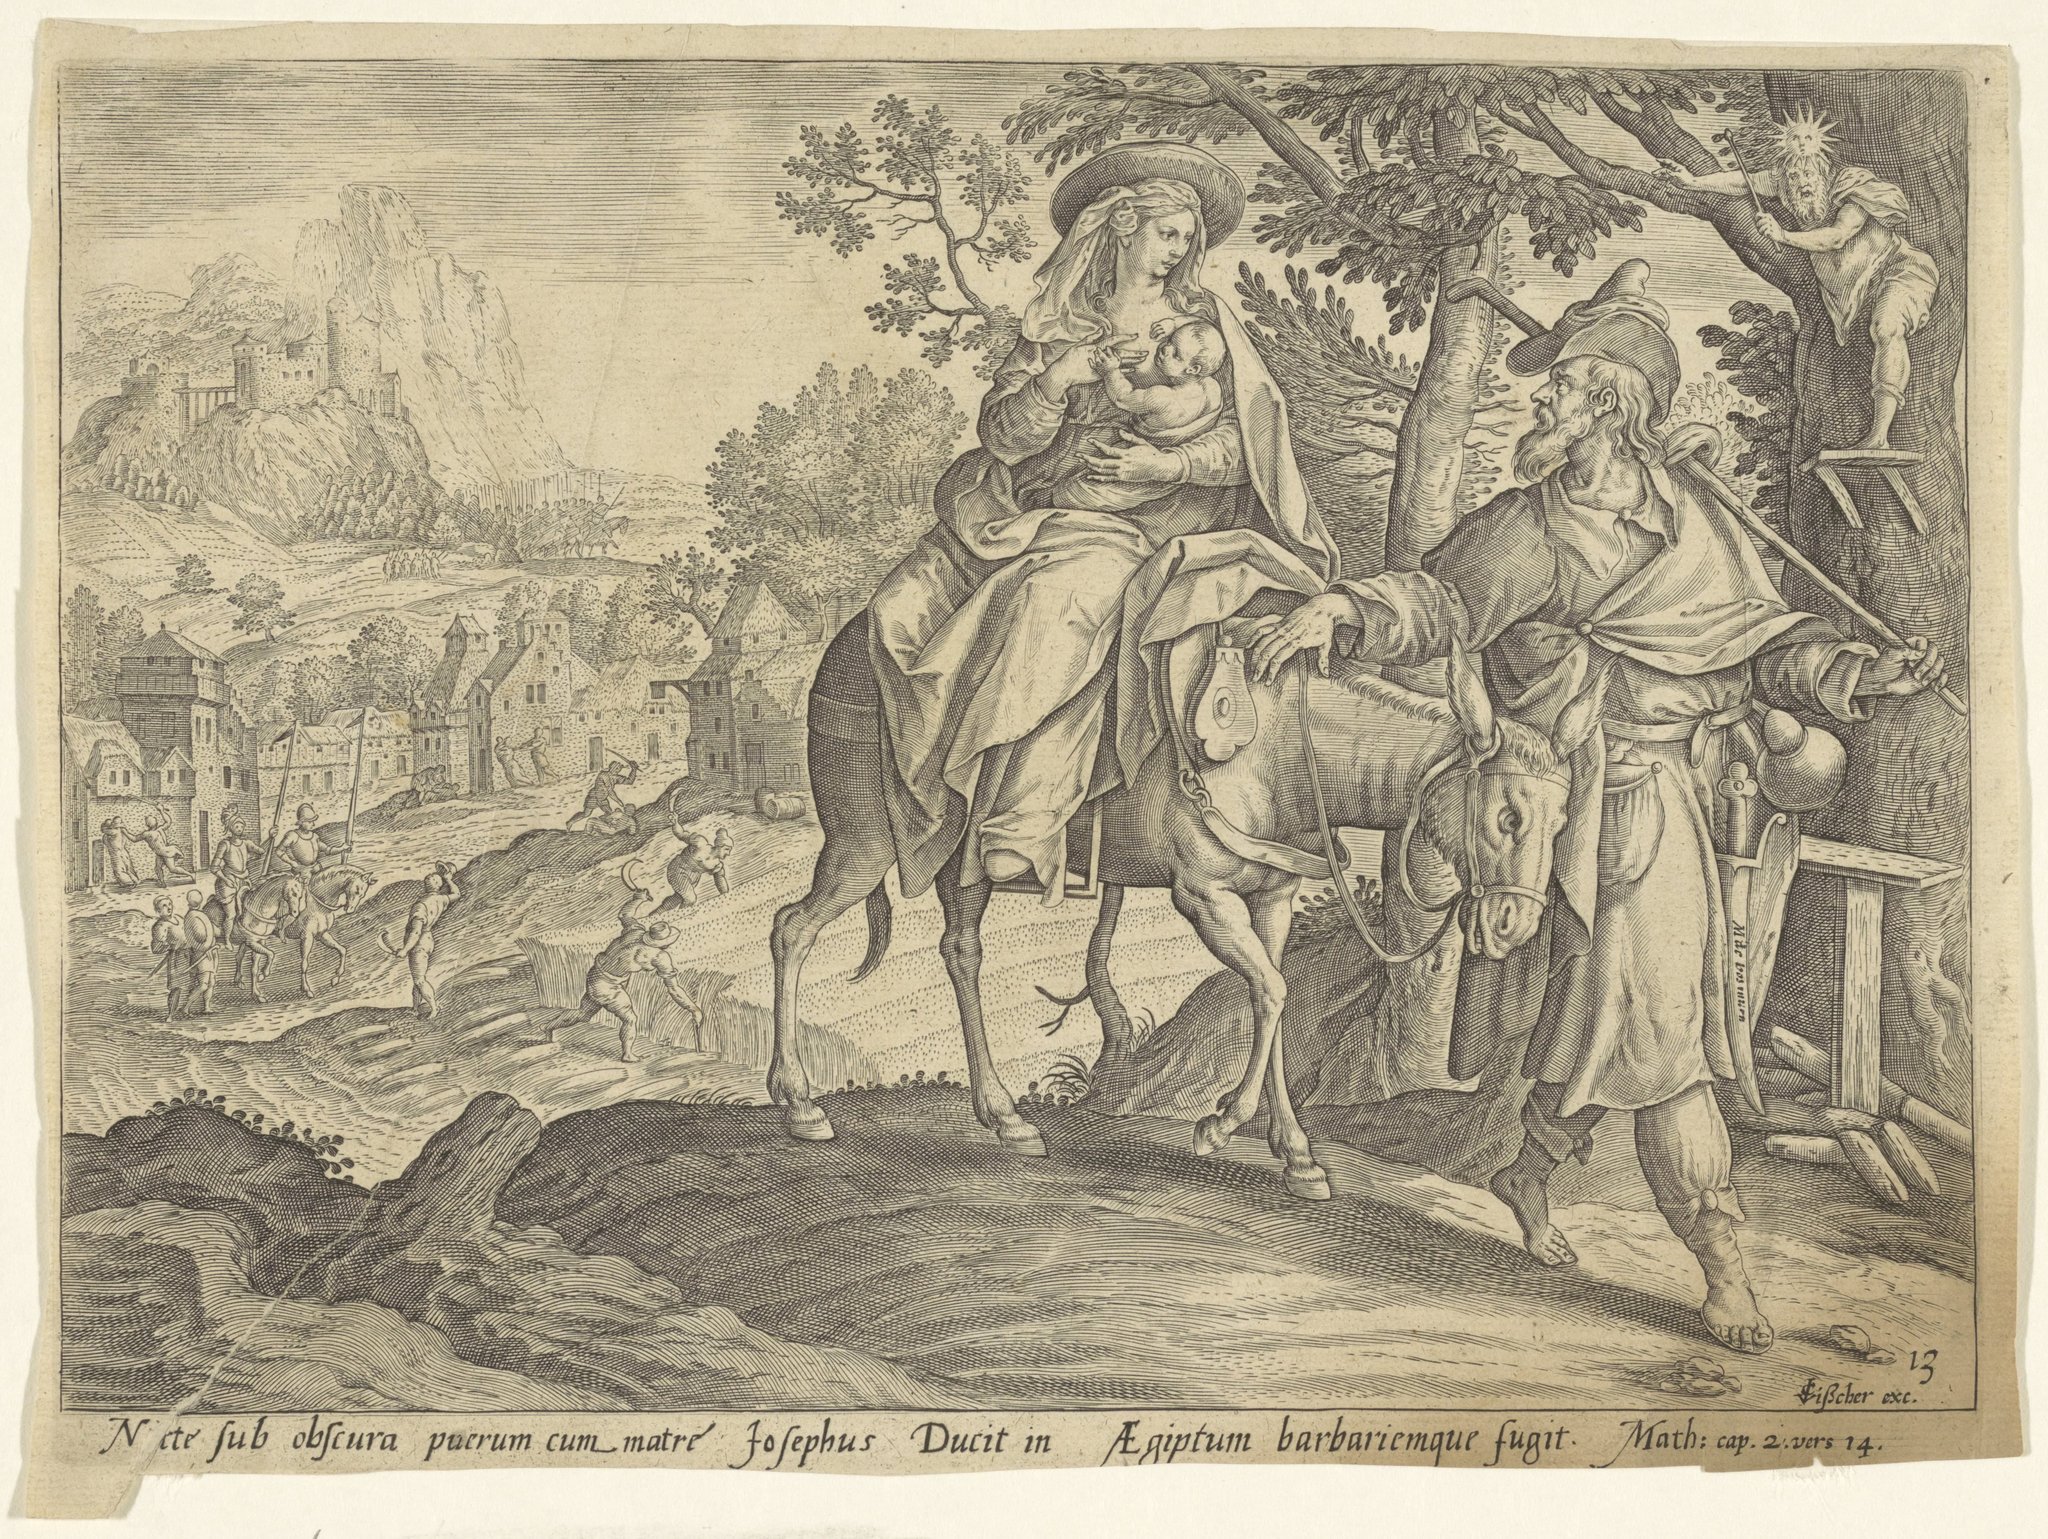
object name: print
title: Theatrum biblicum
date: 1585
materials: paper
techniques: engraving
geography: amsterdam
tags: flight into egypt and miracles during the journey, soldiers of herod questioning the farmer, who is cutting the ripe wheat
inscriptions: collector's mark: Lugt 2228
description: Maria geeft Christus de borst, terwijl zij op de ezel zit tijdens de vlucht naar Egypte. Jozef leidt de ezel. Op de achtergrond de kindermoord te Betlehem en de legende van het snel groeiende koren. Enkele soldaten te paard vragen aan een boer of hij een familie voorbij heeft zien gaan. De boer vertelt dat hij het gezin zag toen hij het koren inzaaide. Daarop concluderen de soldaten dat dat erg lang geleden moet zijn en zij staken de zoektocht. Rechts tegen de boom een figuur met een zon op zijn hoofd. Wellicht heeft hij het koren snel laten groeien. Onder de voorstelling een verwijzing in het Latijn naar de Bijbeltekst in Mat. 2. Rechtsonder het serienummer: 13.